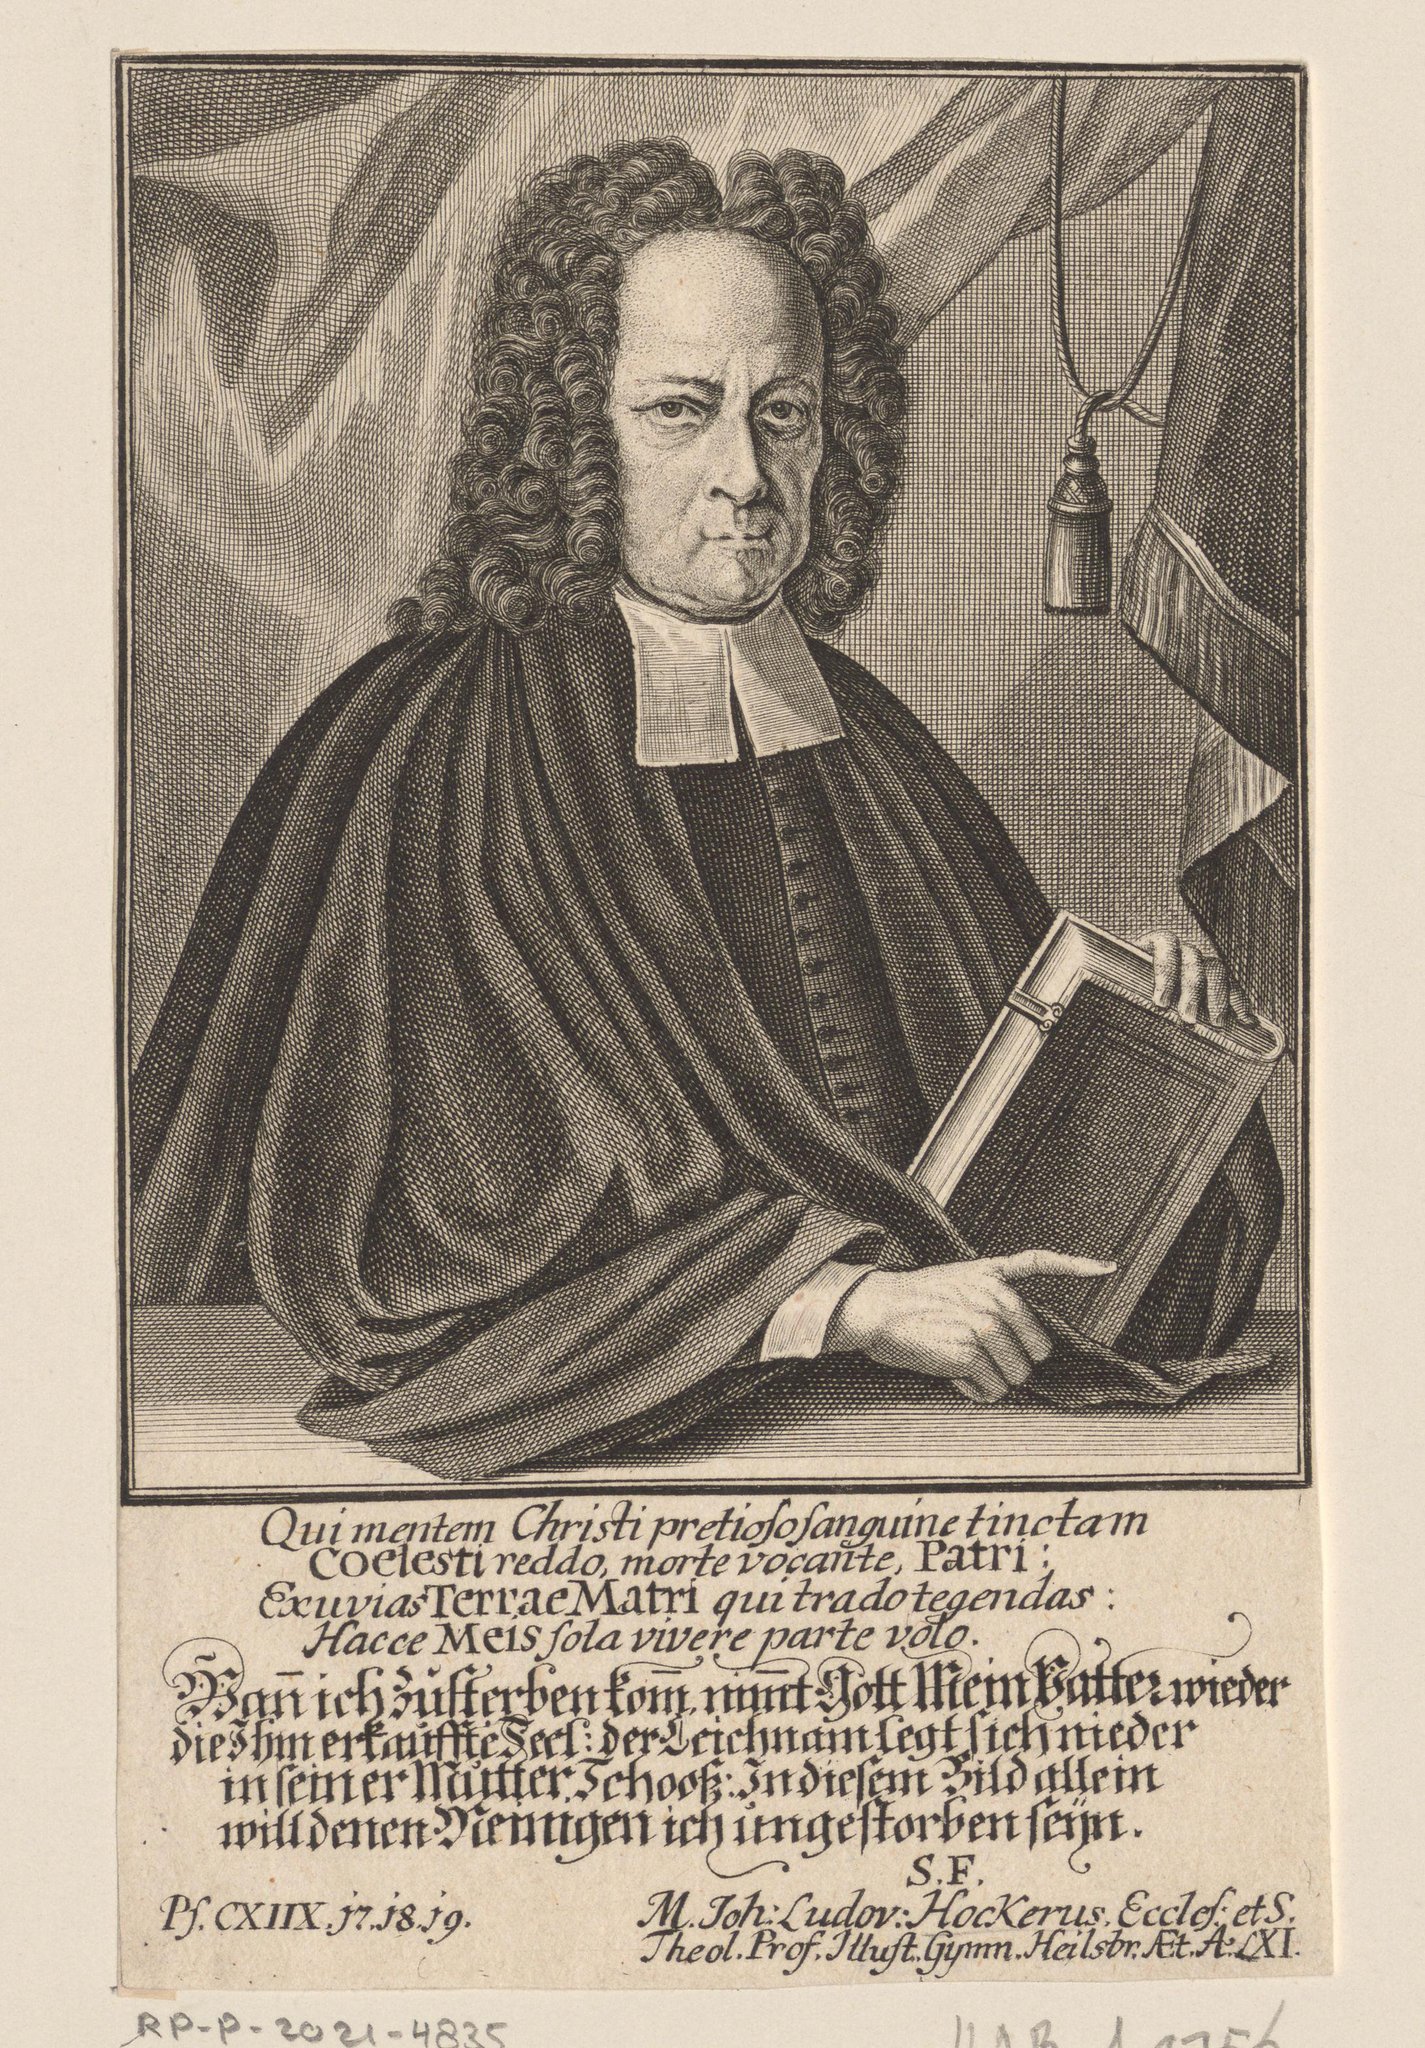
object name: book illustration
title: Portret van Johann Ludwig Hocker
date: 1731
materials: paper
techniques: engraving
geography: nuremberg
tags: theologian, historical persons, book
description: Prent uit: Hocker, Johann Ludwig. Hailsbronnischer Antiquitäten-Schatz (...). Neurenberg: Peter Conrad Monath, 1731.